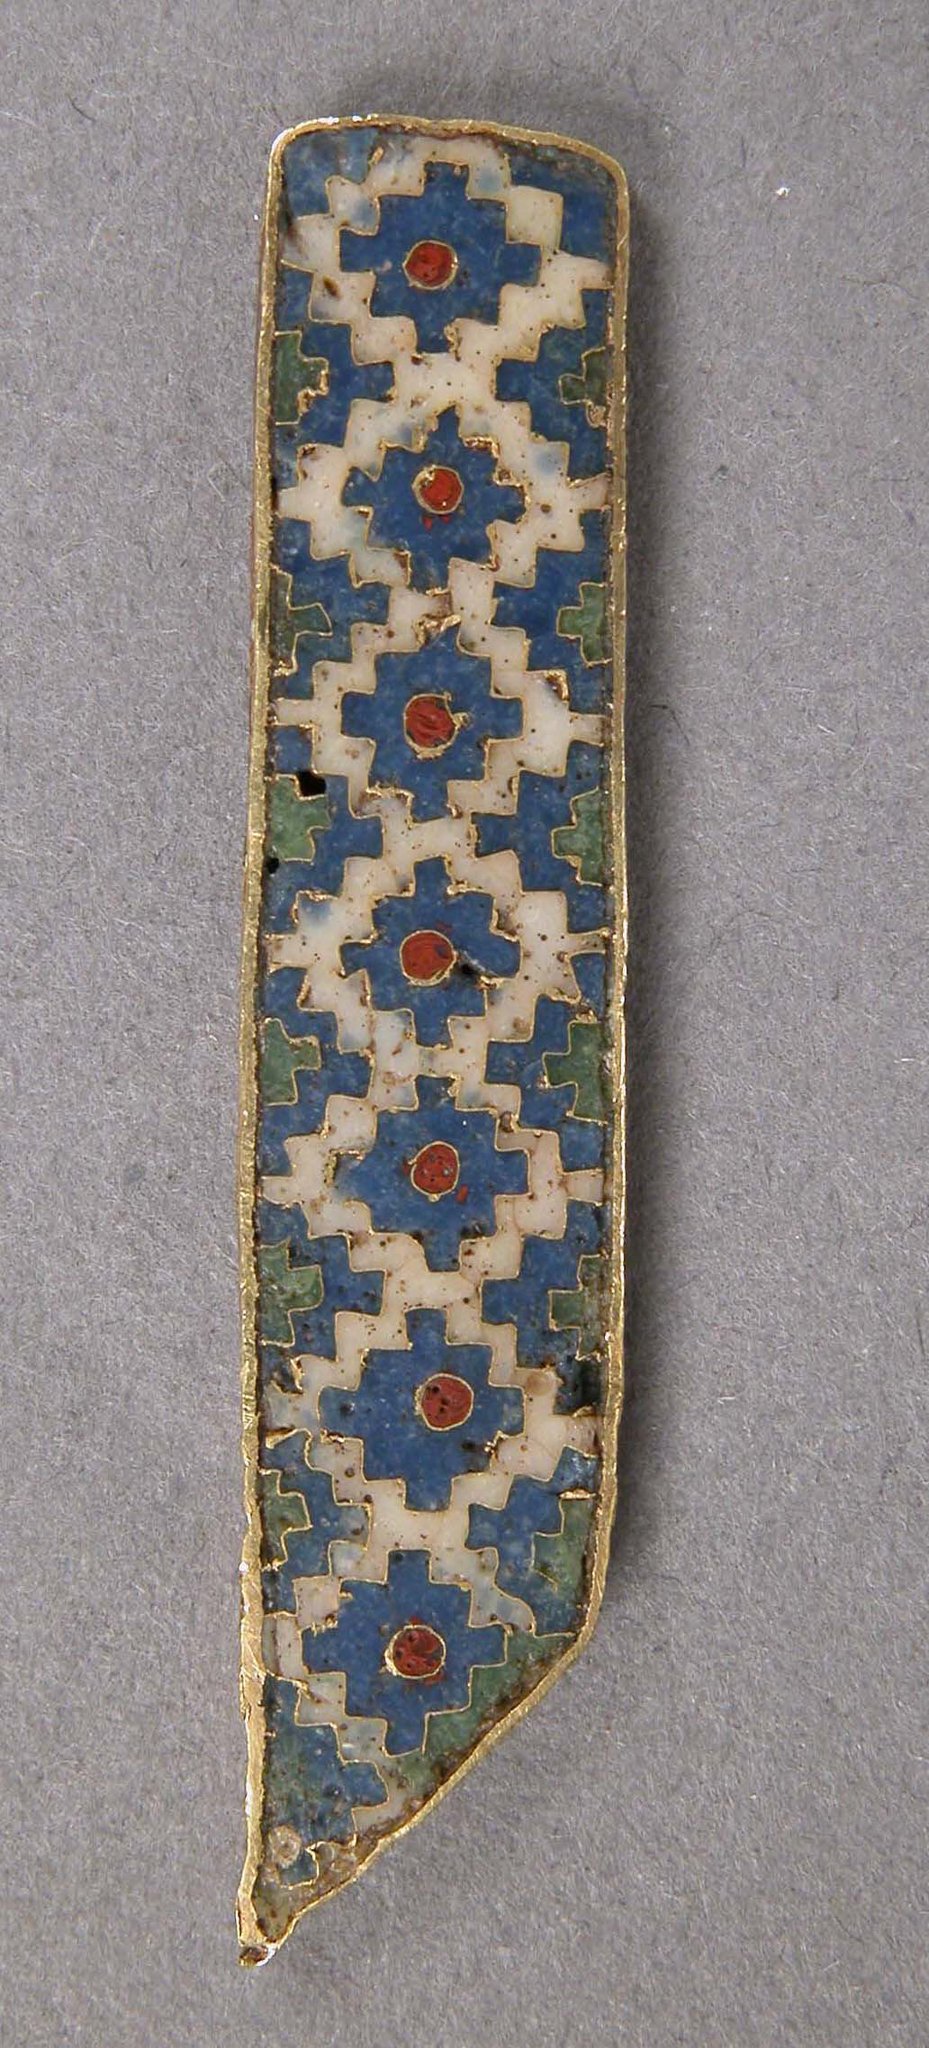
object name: border fragment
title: Element of a Border for an Icon Frame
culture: byzantine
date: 901-1000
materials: enamel, gold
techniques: enamel